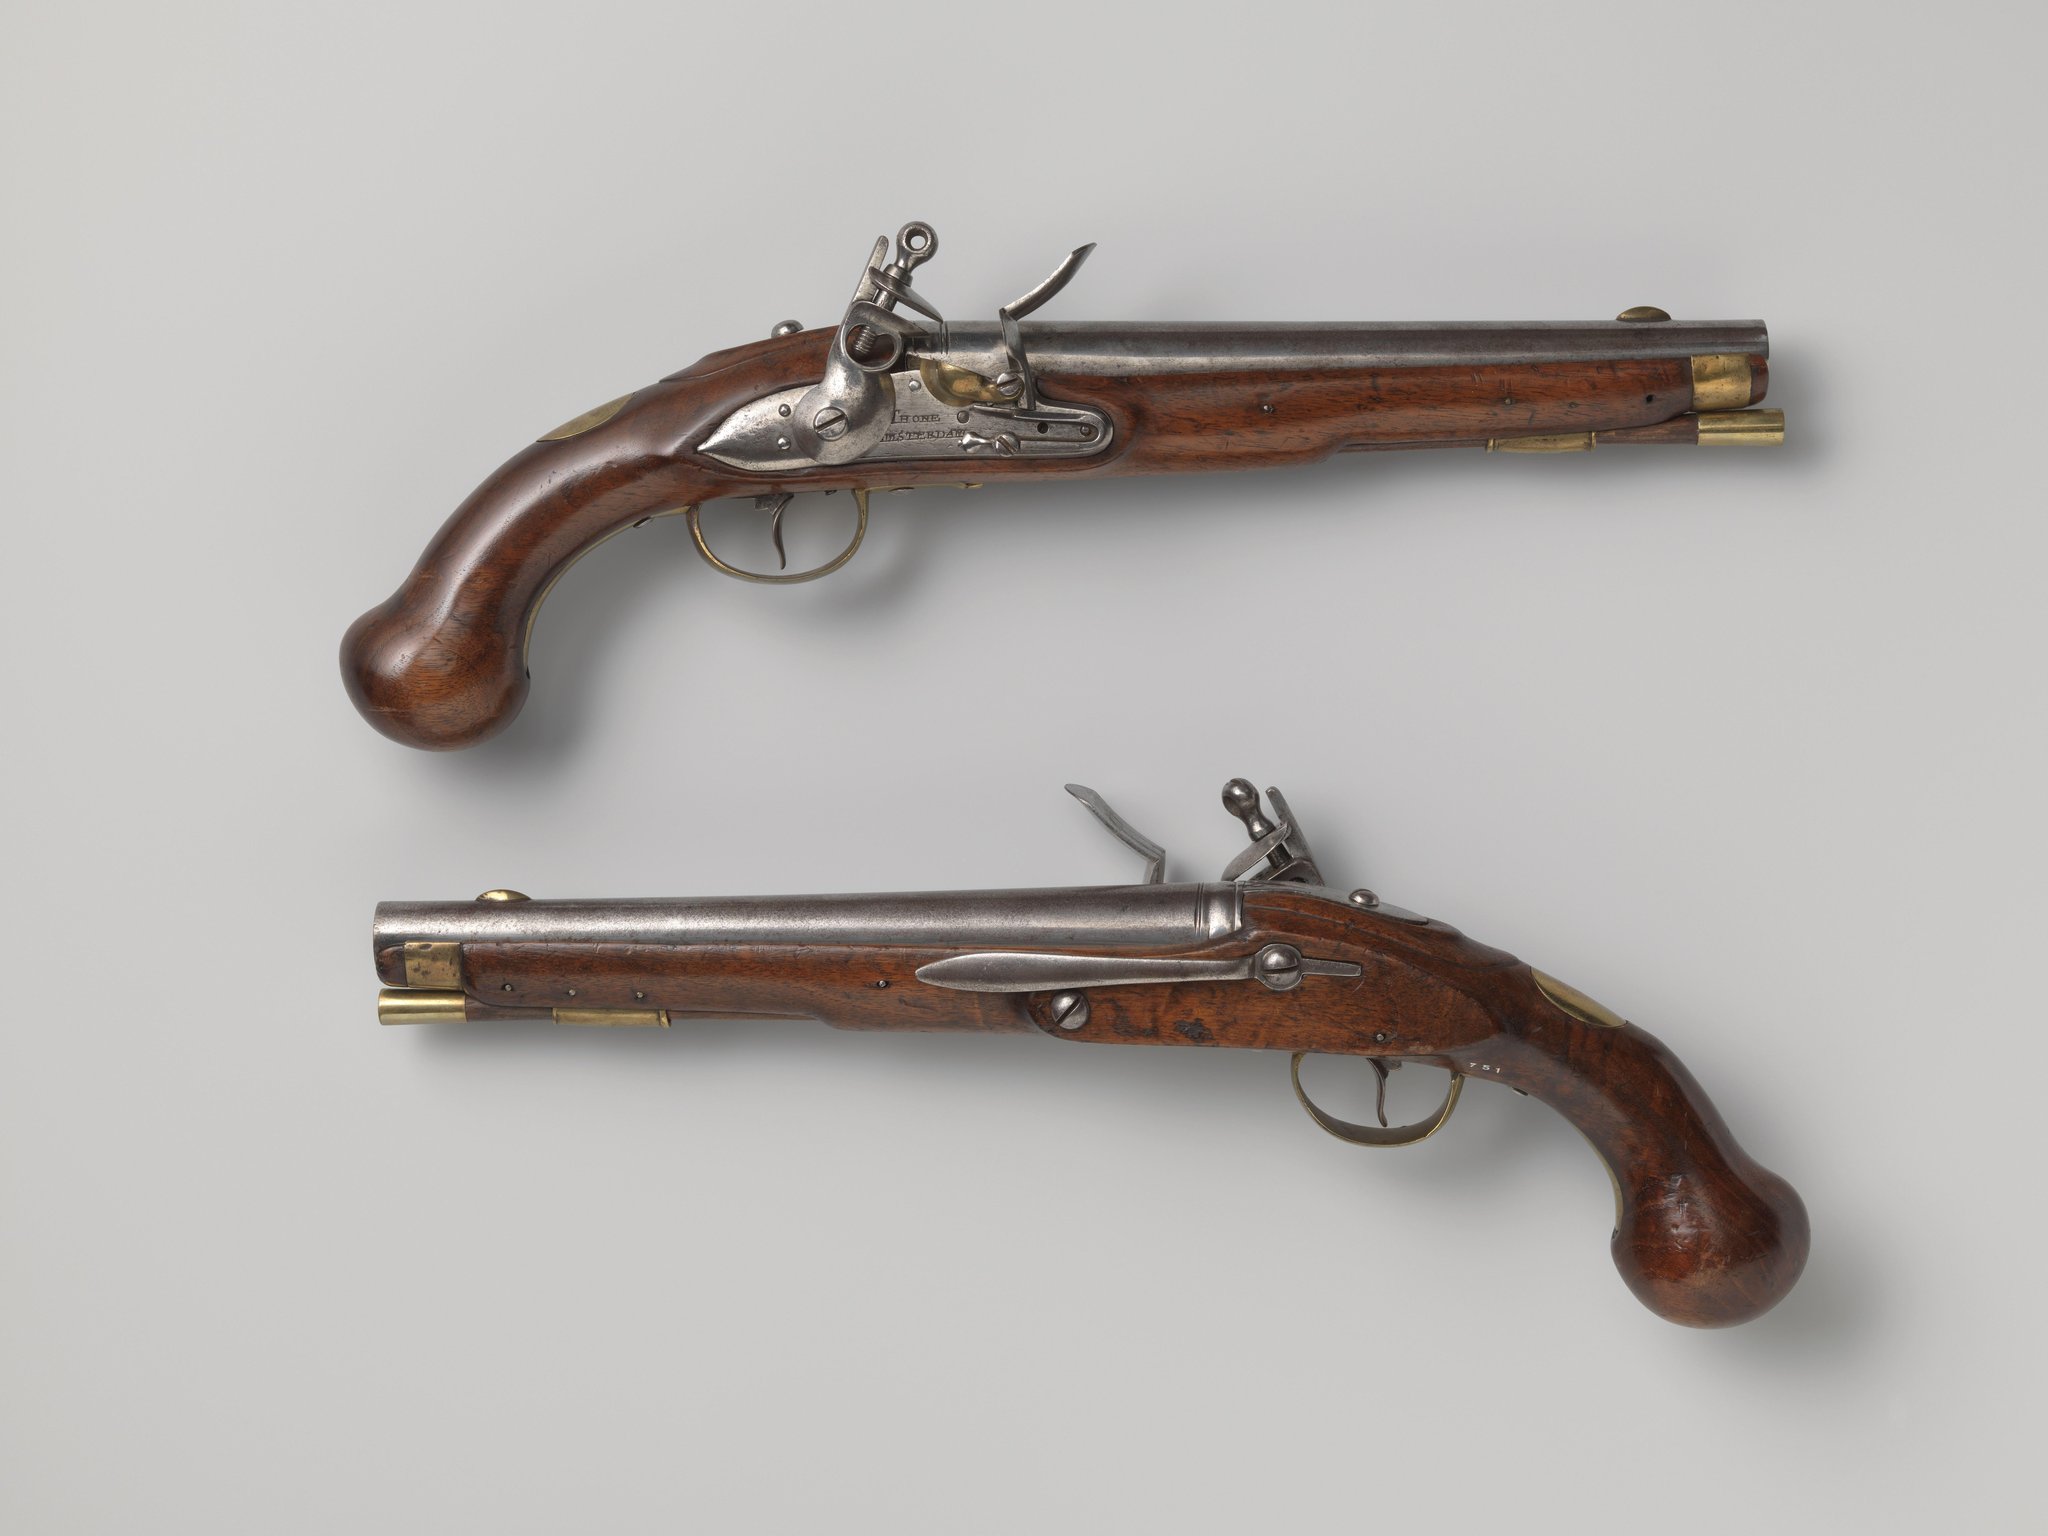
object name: flintlock pistol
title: Vuursteen gordelpistool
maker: lambertus michaelis thone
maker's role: weapon manufacturer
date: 1790-1795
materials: brass, iron, wood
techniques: printing, cutting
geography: amsterdam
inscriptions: signature: ‘THONE // AMSTERDAM’, coat of arms: ‘HH’, : ‘M’, mark